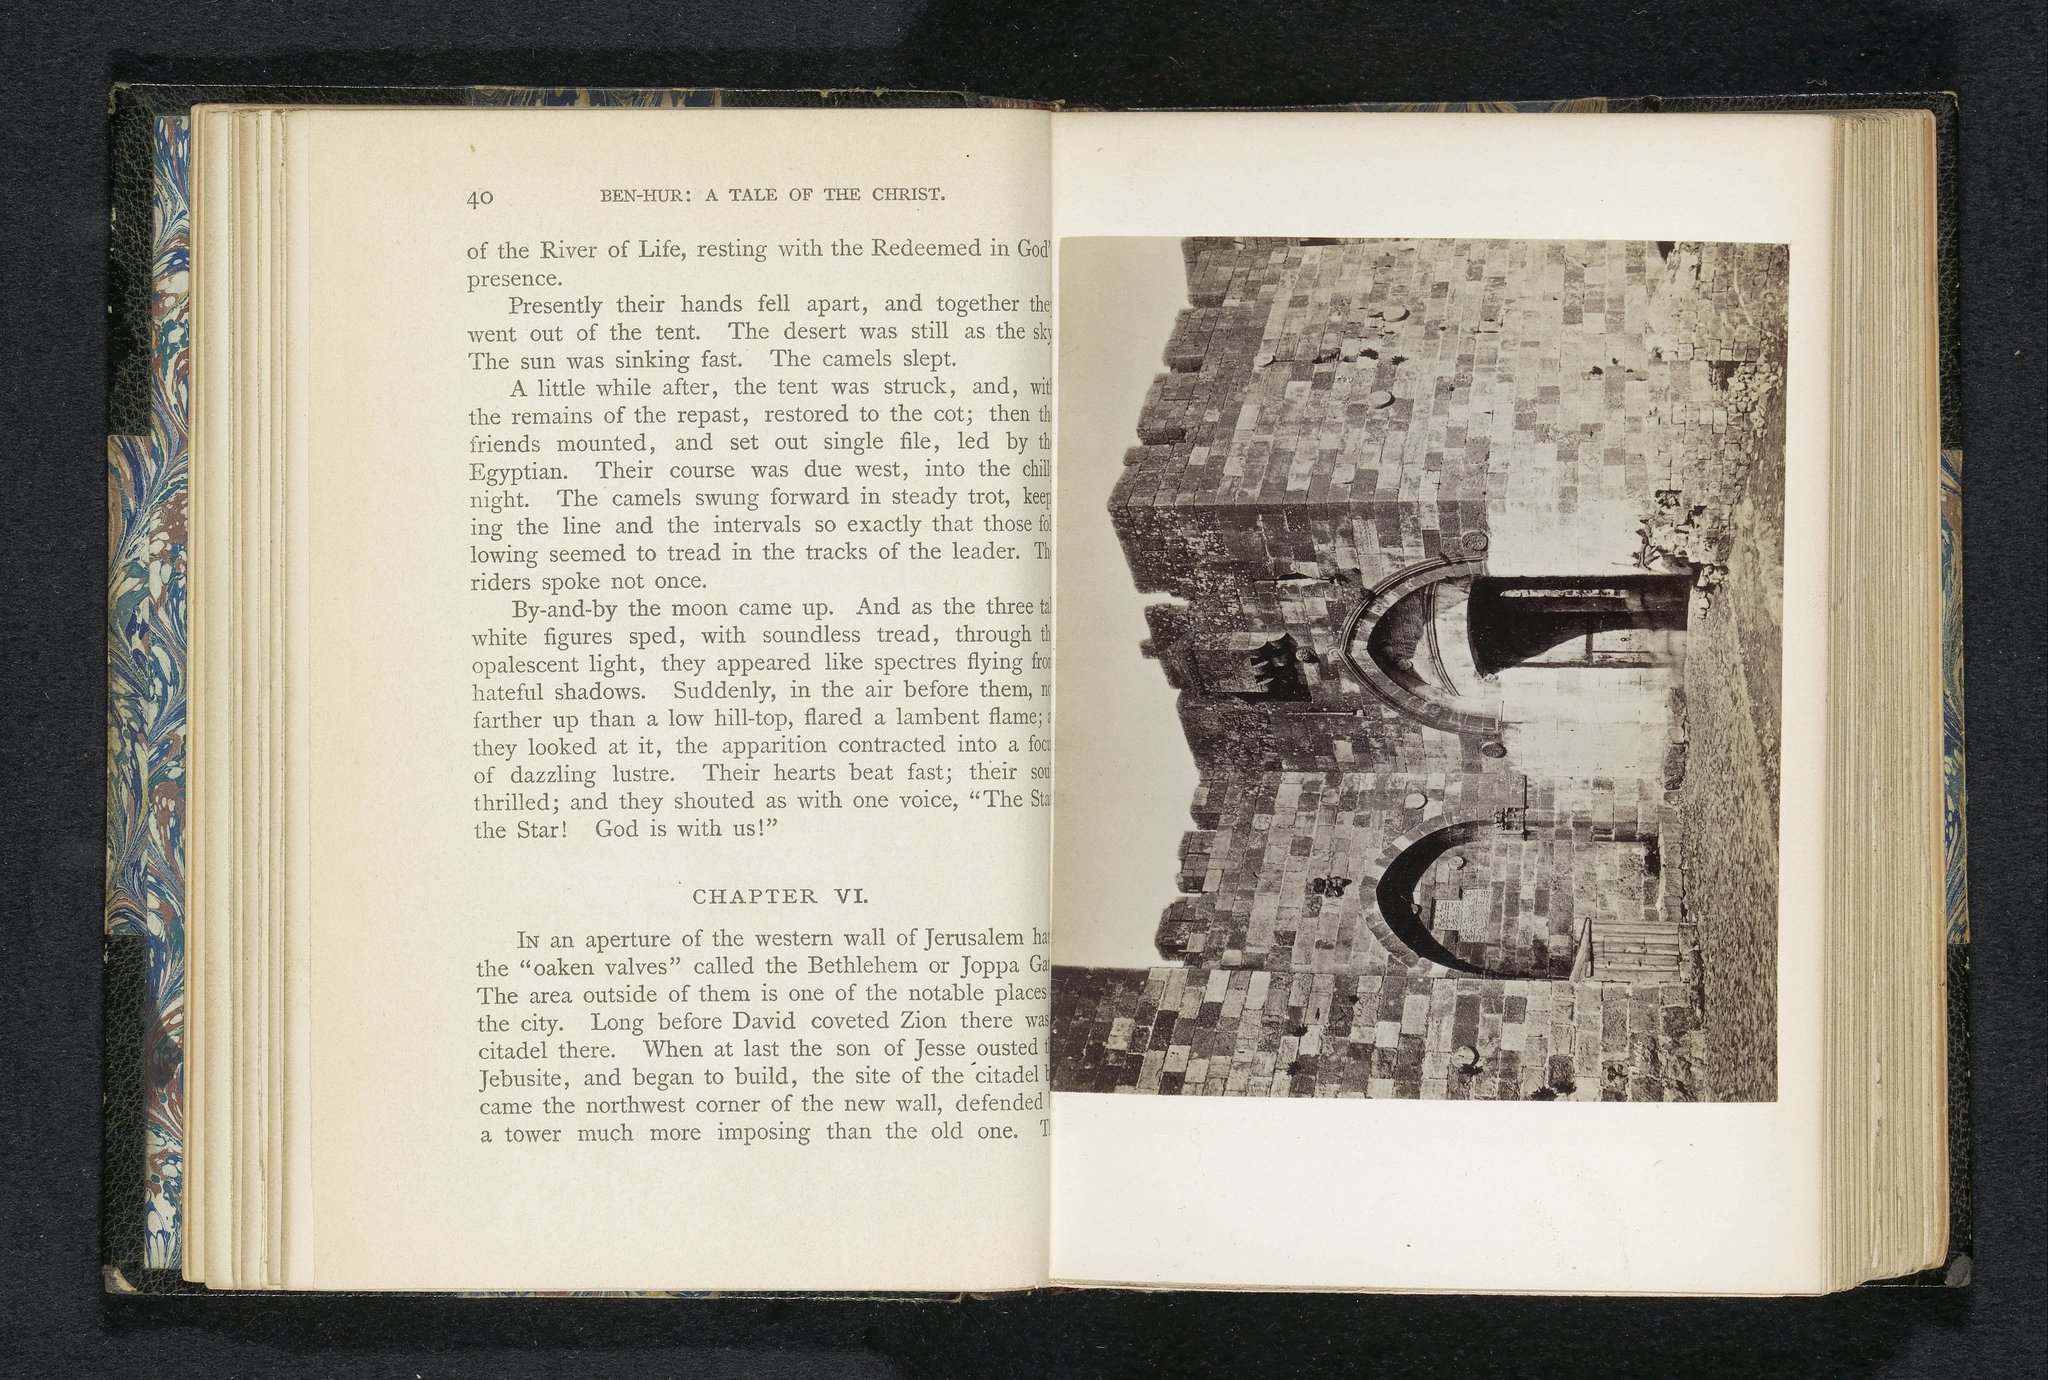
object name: photograph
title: Jaffapoort te Jeruzalem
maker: Anonymous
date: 1883-1888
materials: photographic support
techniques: albumen print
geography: jerusalem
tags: city-gate